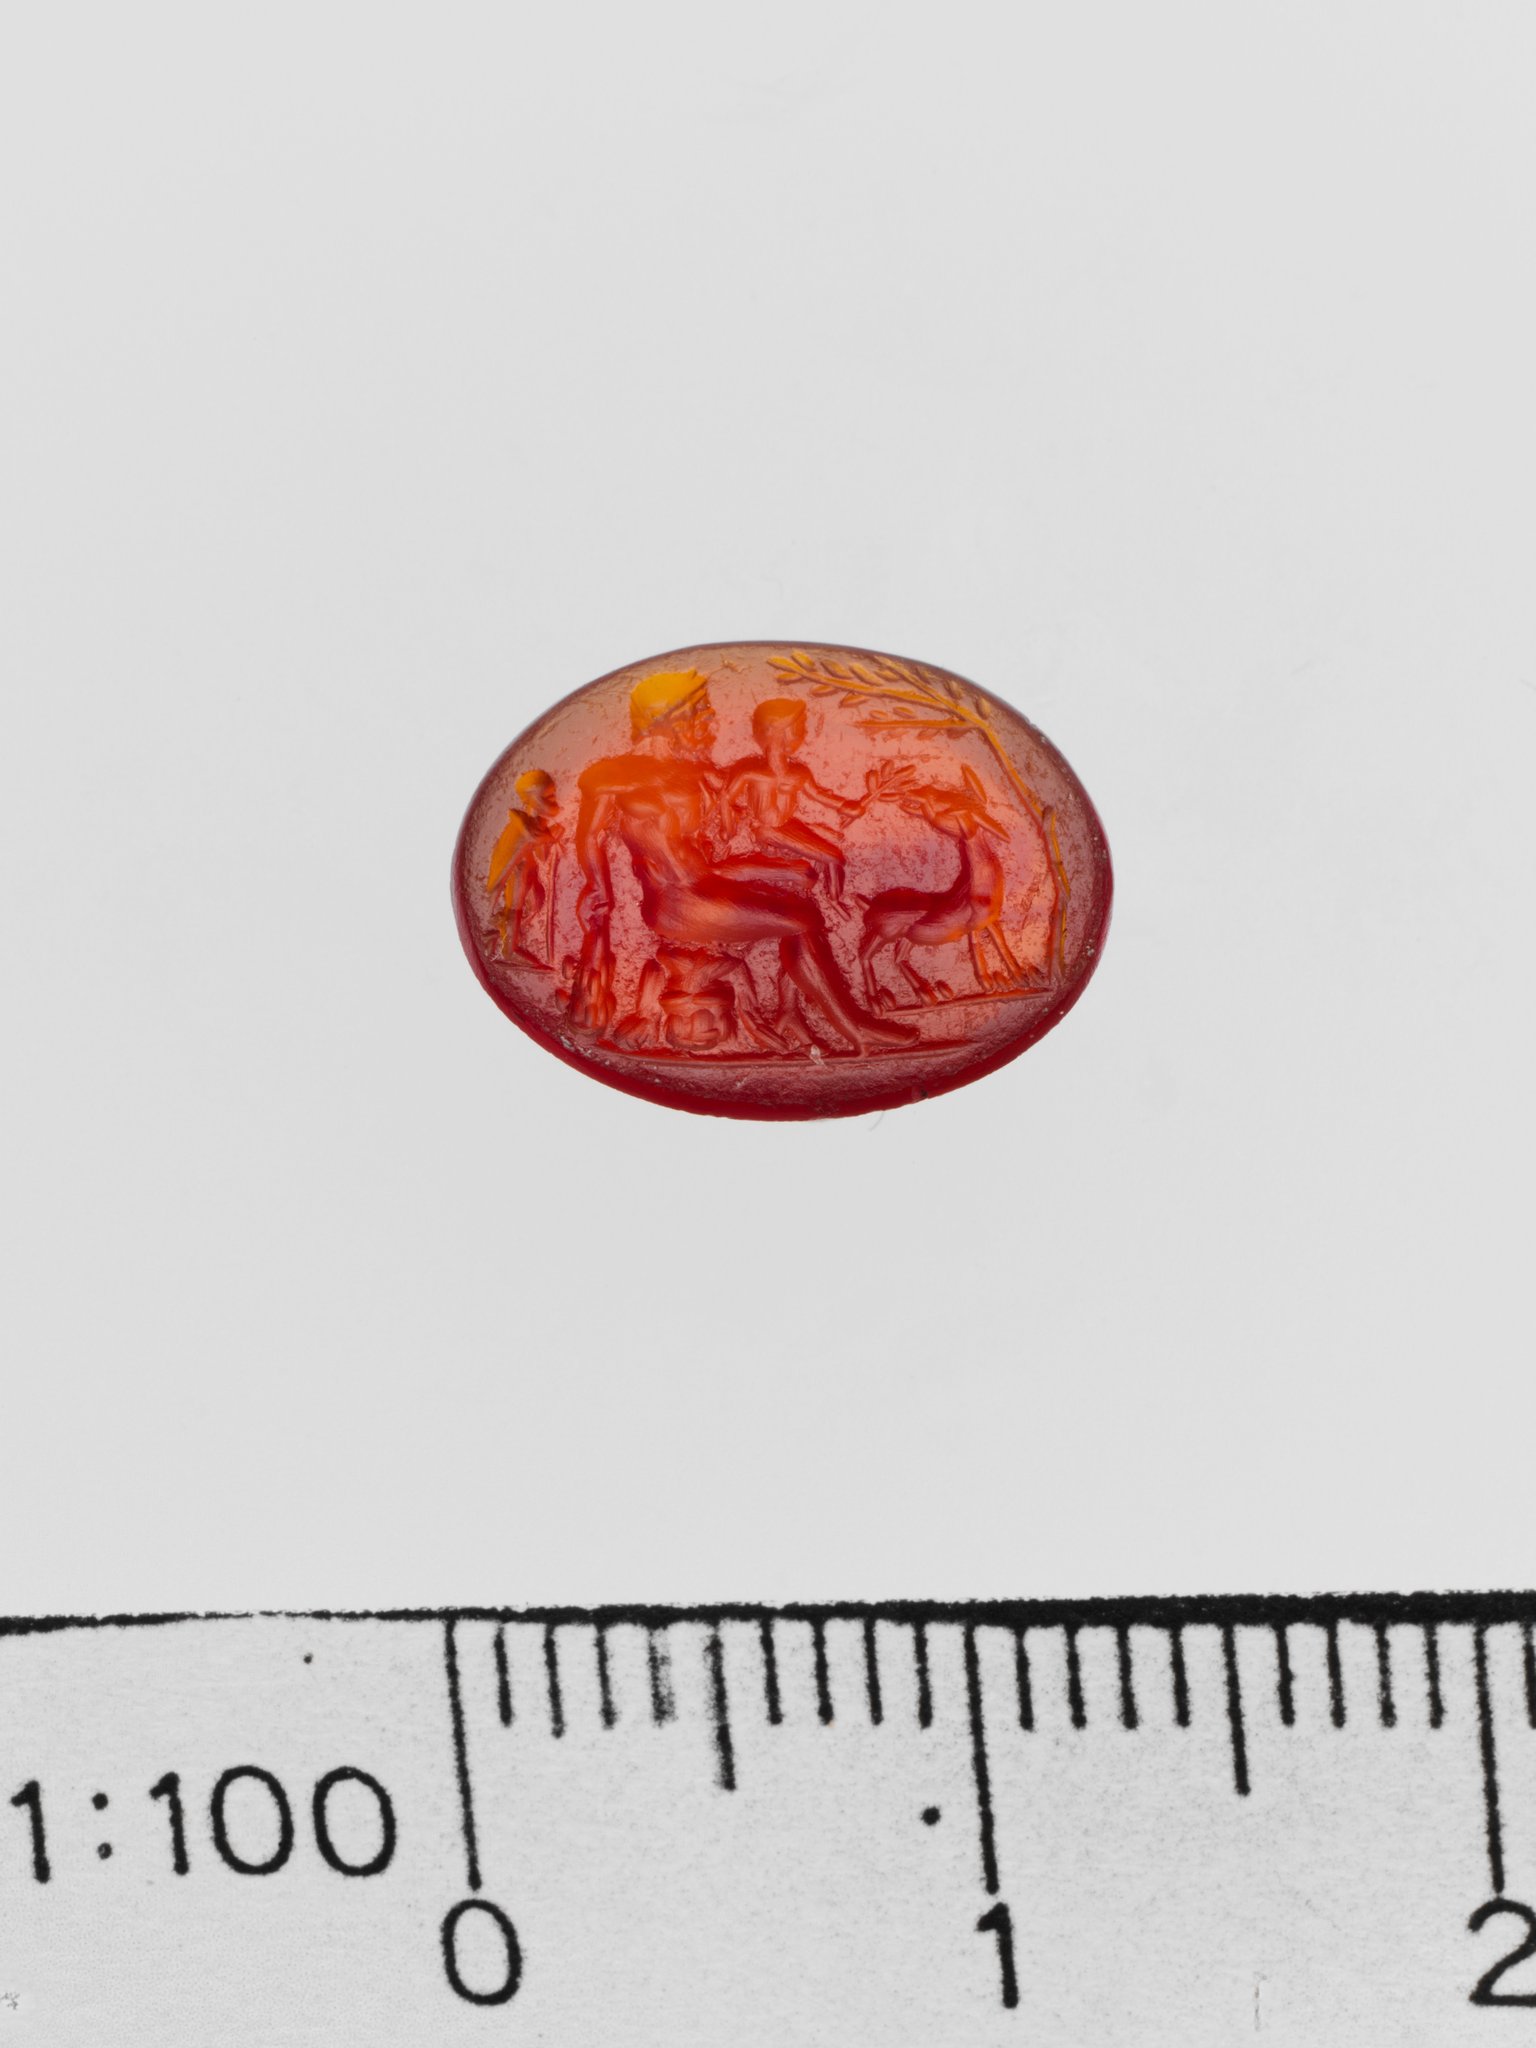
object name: intaglio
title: Carnelian ring stone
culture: roman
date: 1-100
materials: gemstone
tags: animals,boys,herakles